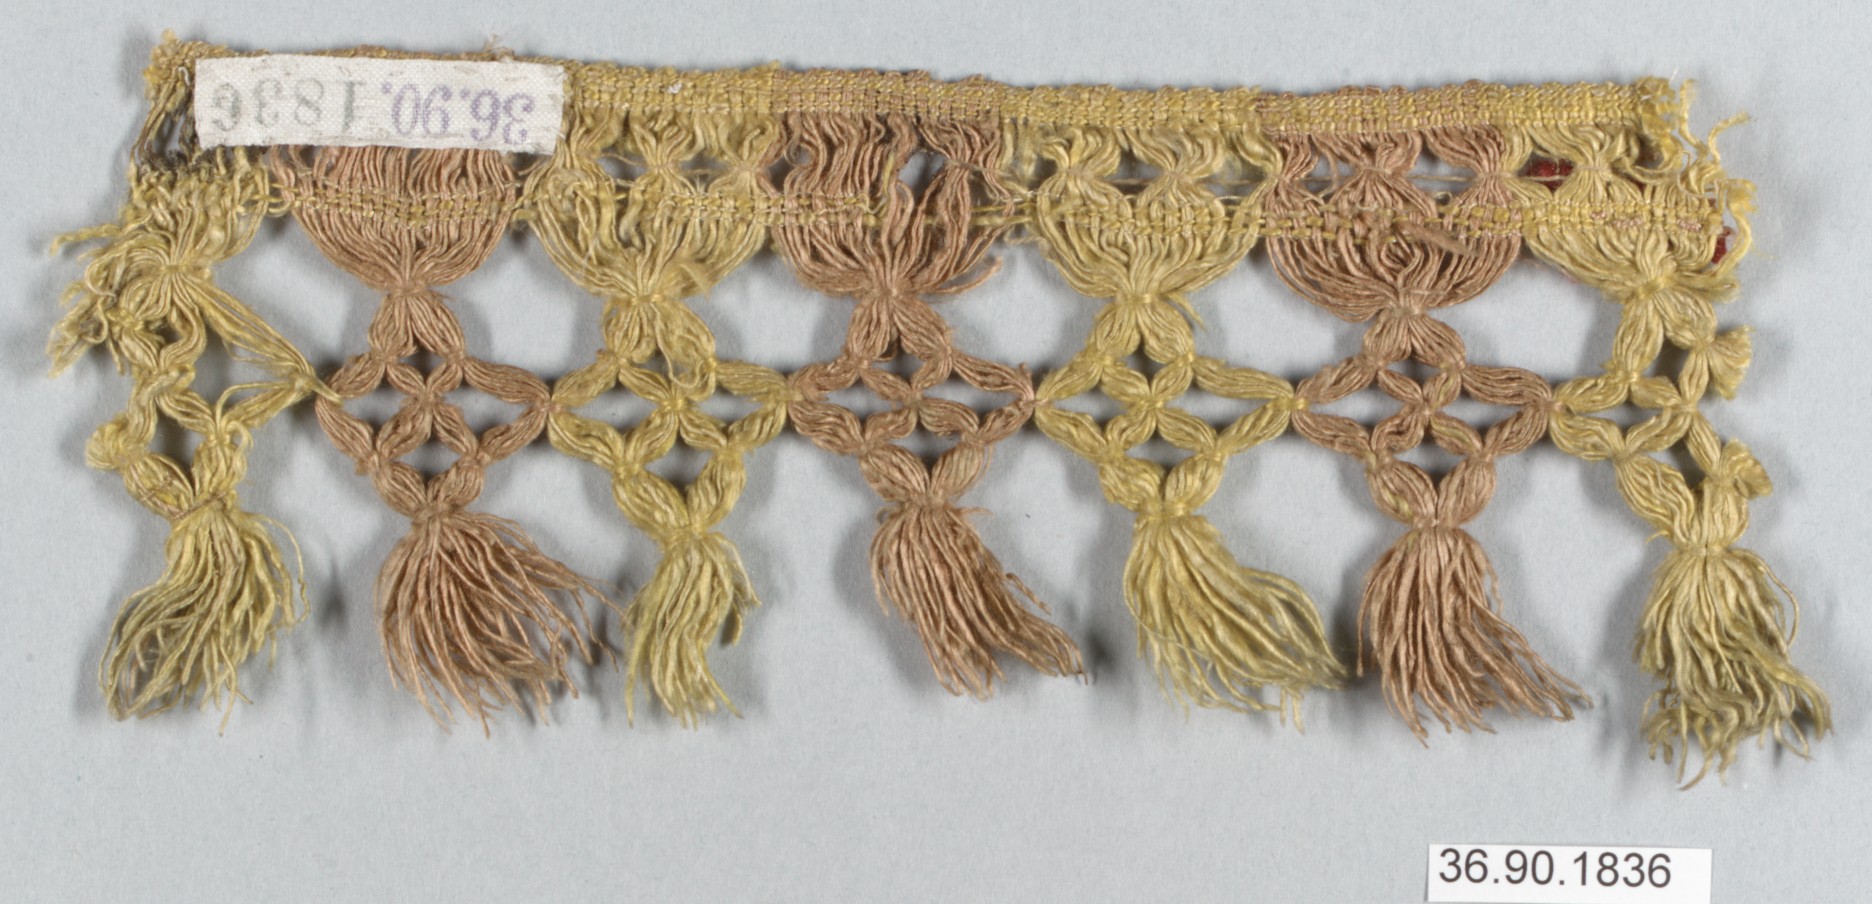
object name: fringe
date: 1601-1700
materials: silk